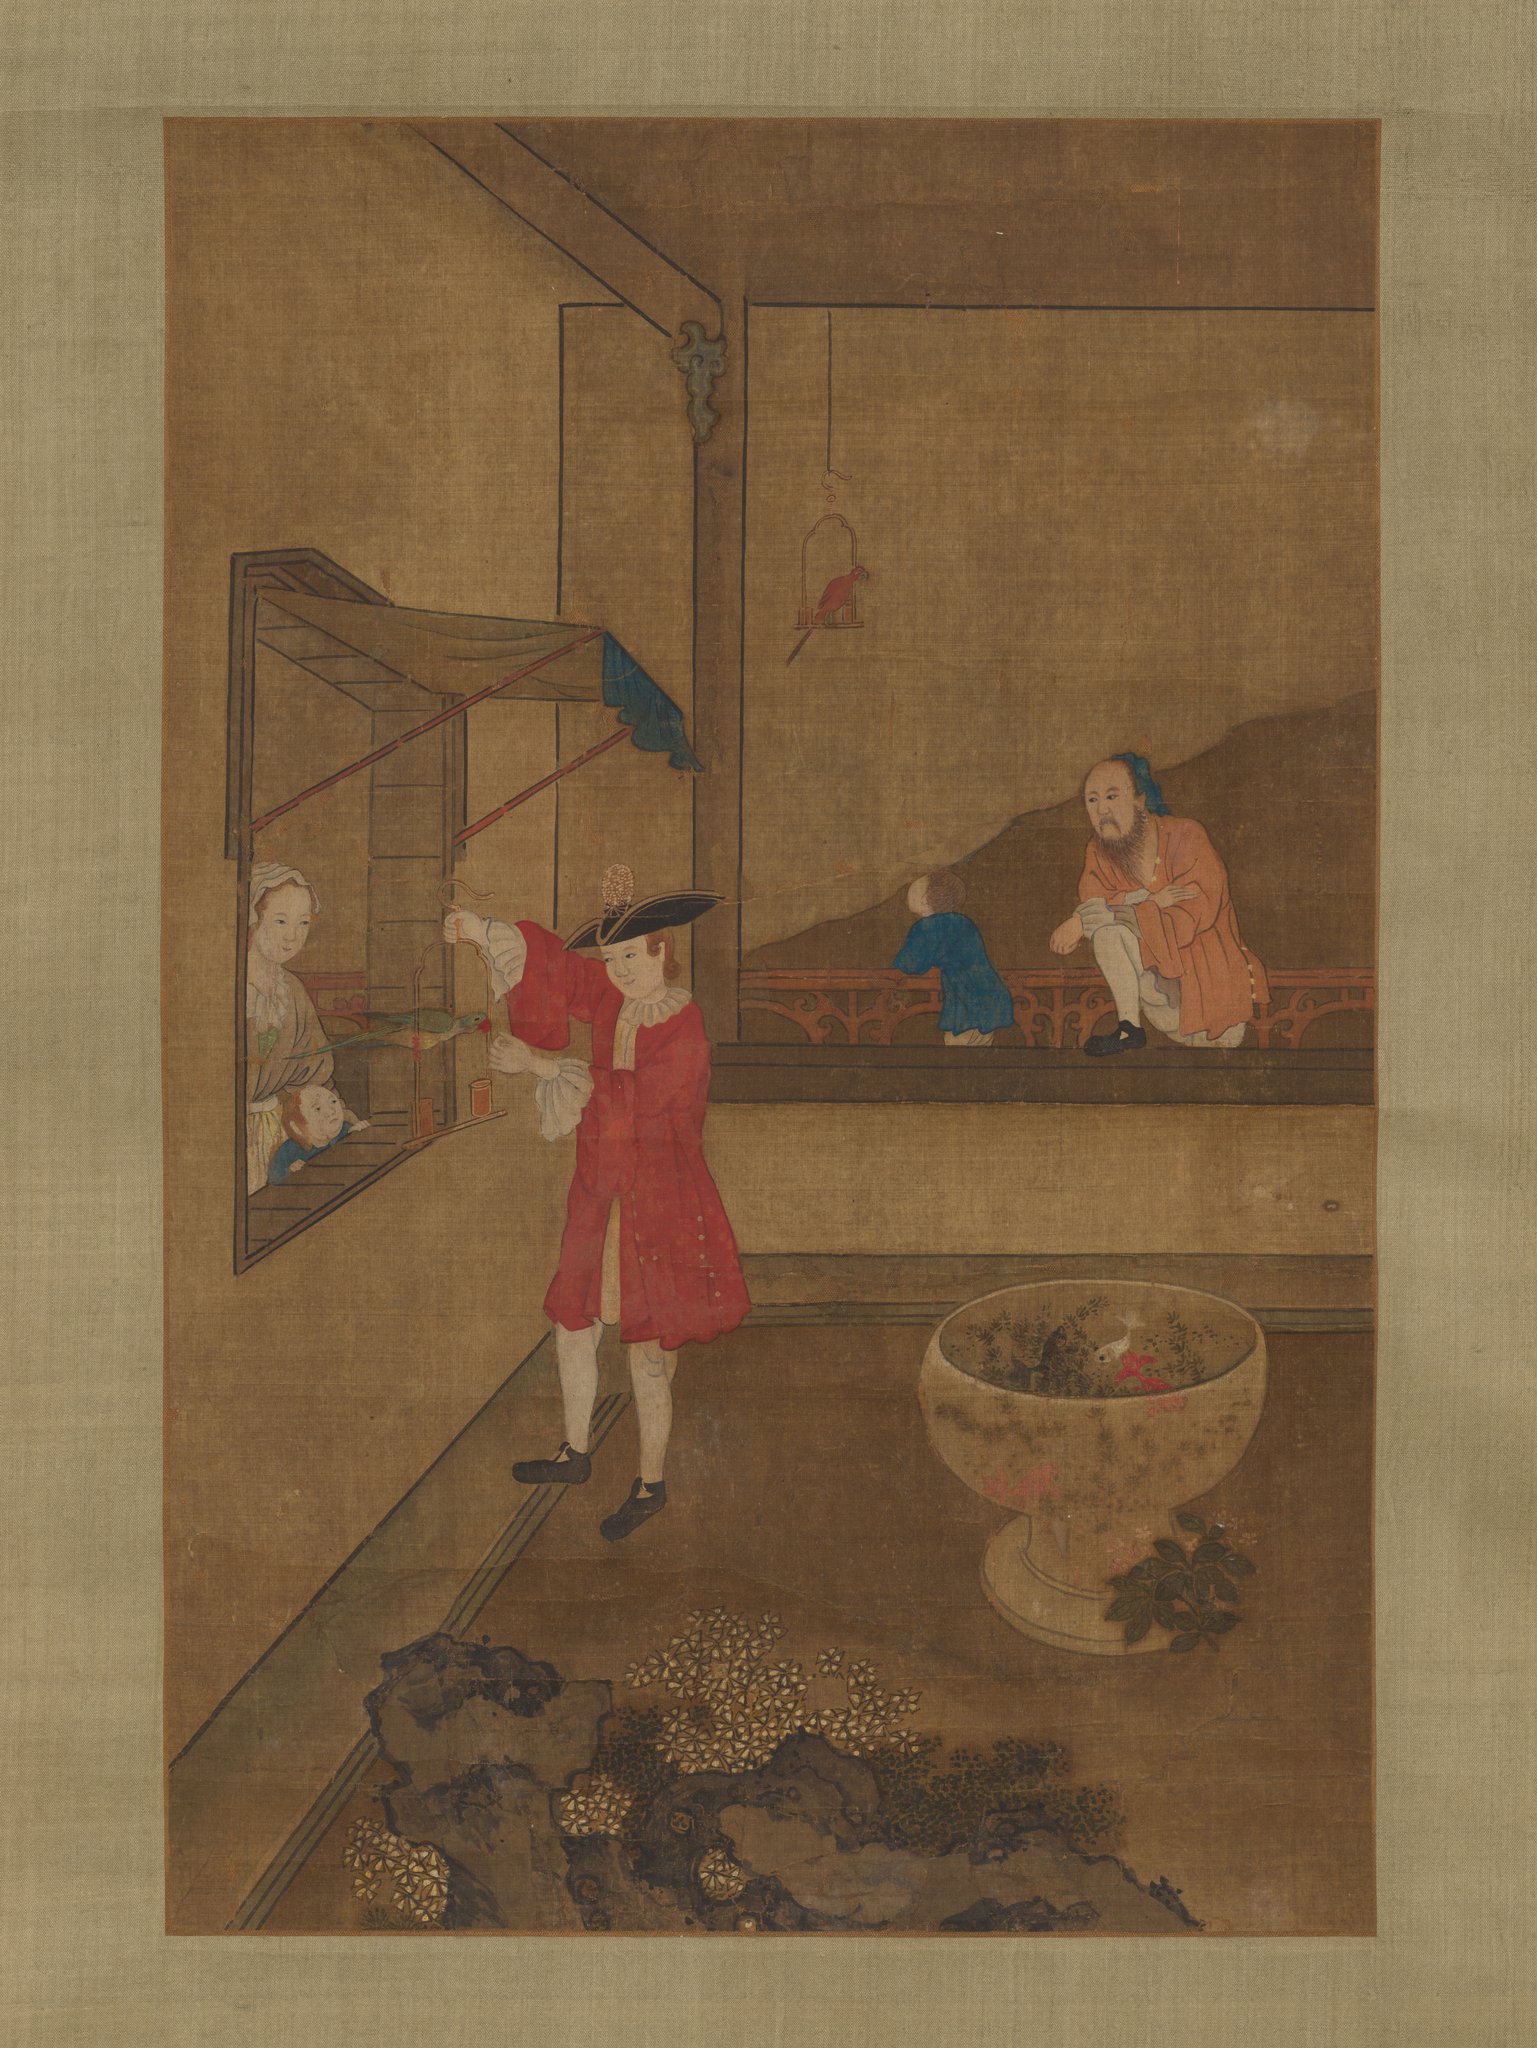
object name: hanging scroll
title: European Couple and Child Playing with Parrot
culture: chinese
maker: unidentified artist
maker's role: artist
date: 1701-1800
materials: ink, silk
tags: boys,couples,playing,parrots,fish